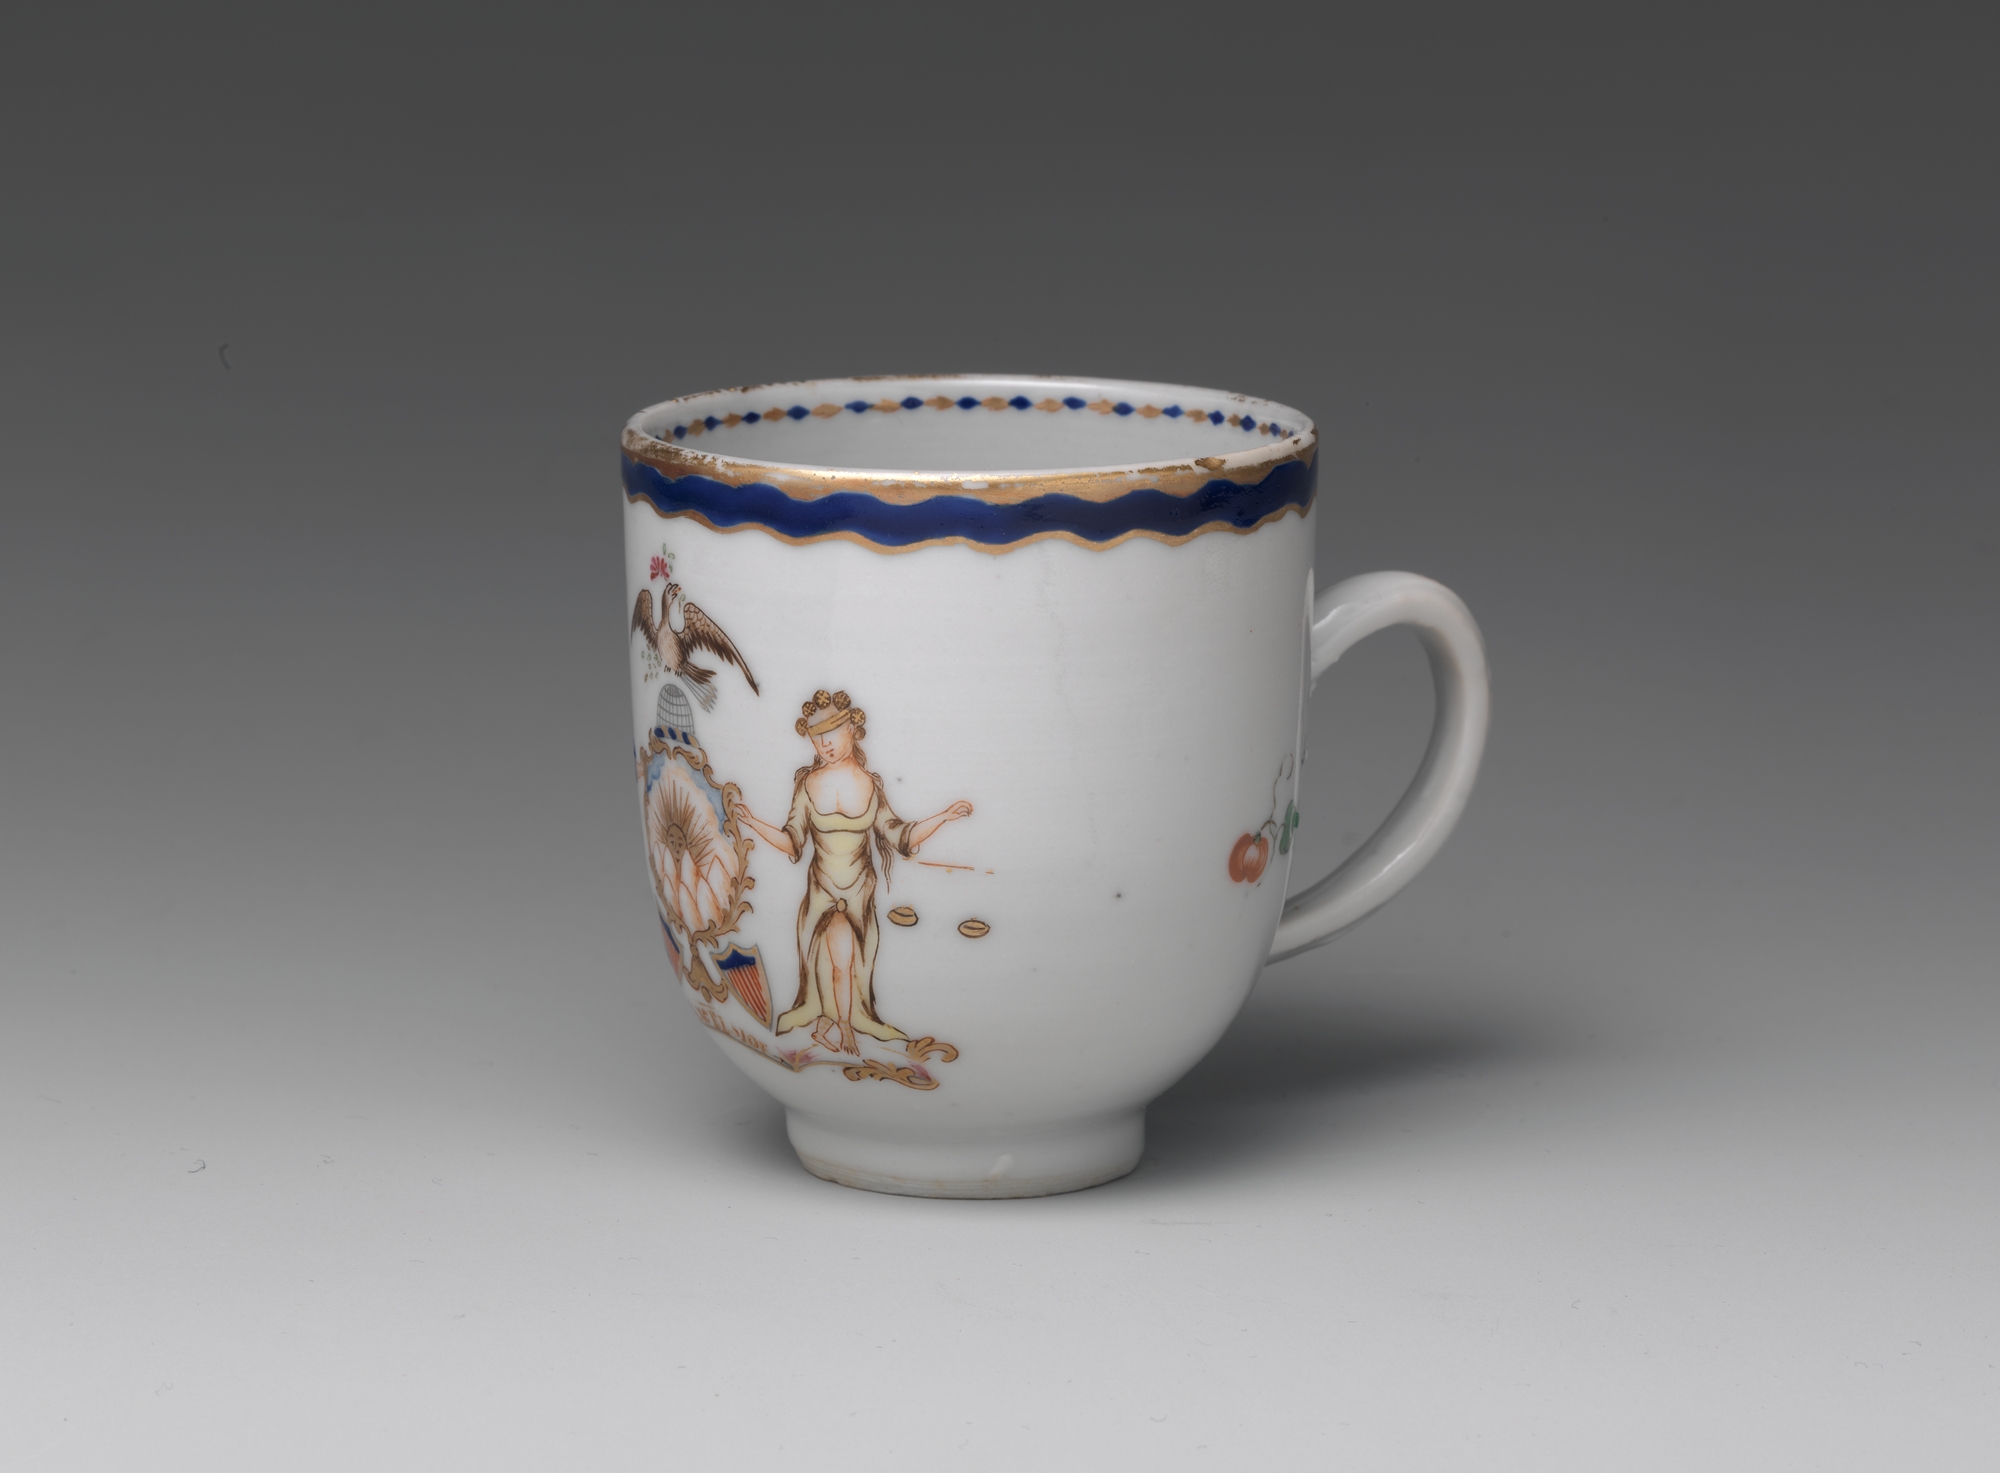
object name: cup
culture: chinese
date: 1785-1805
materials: porcelain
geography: china